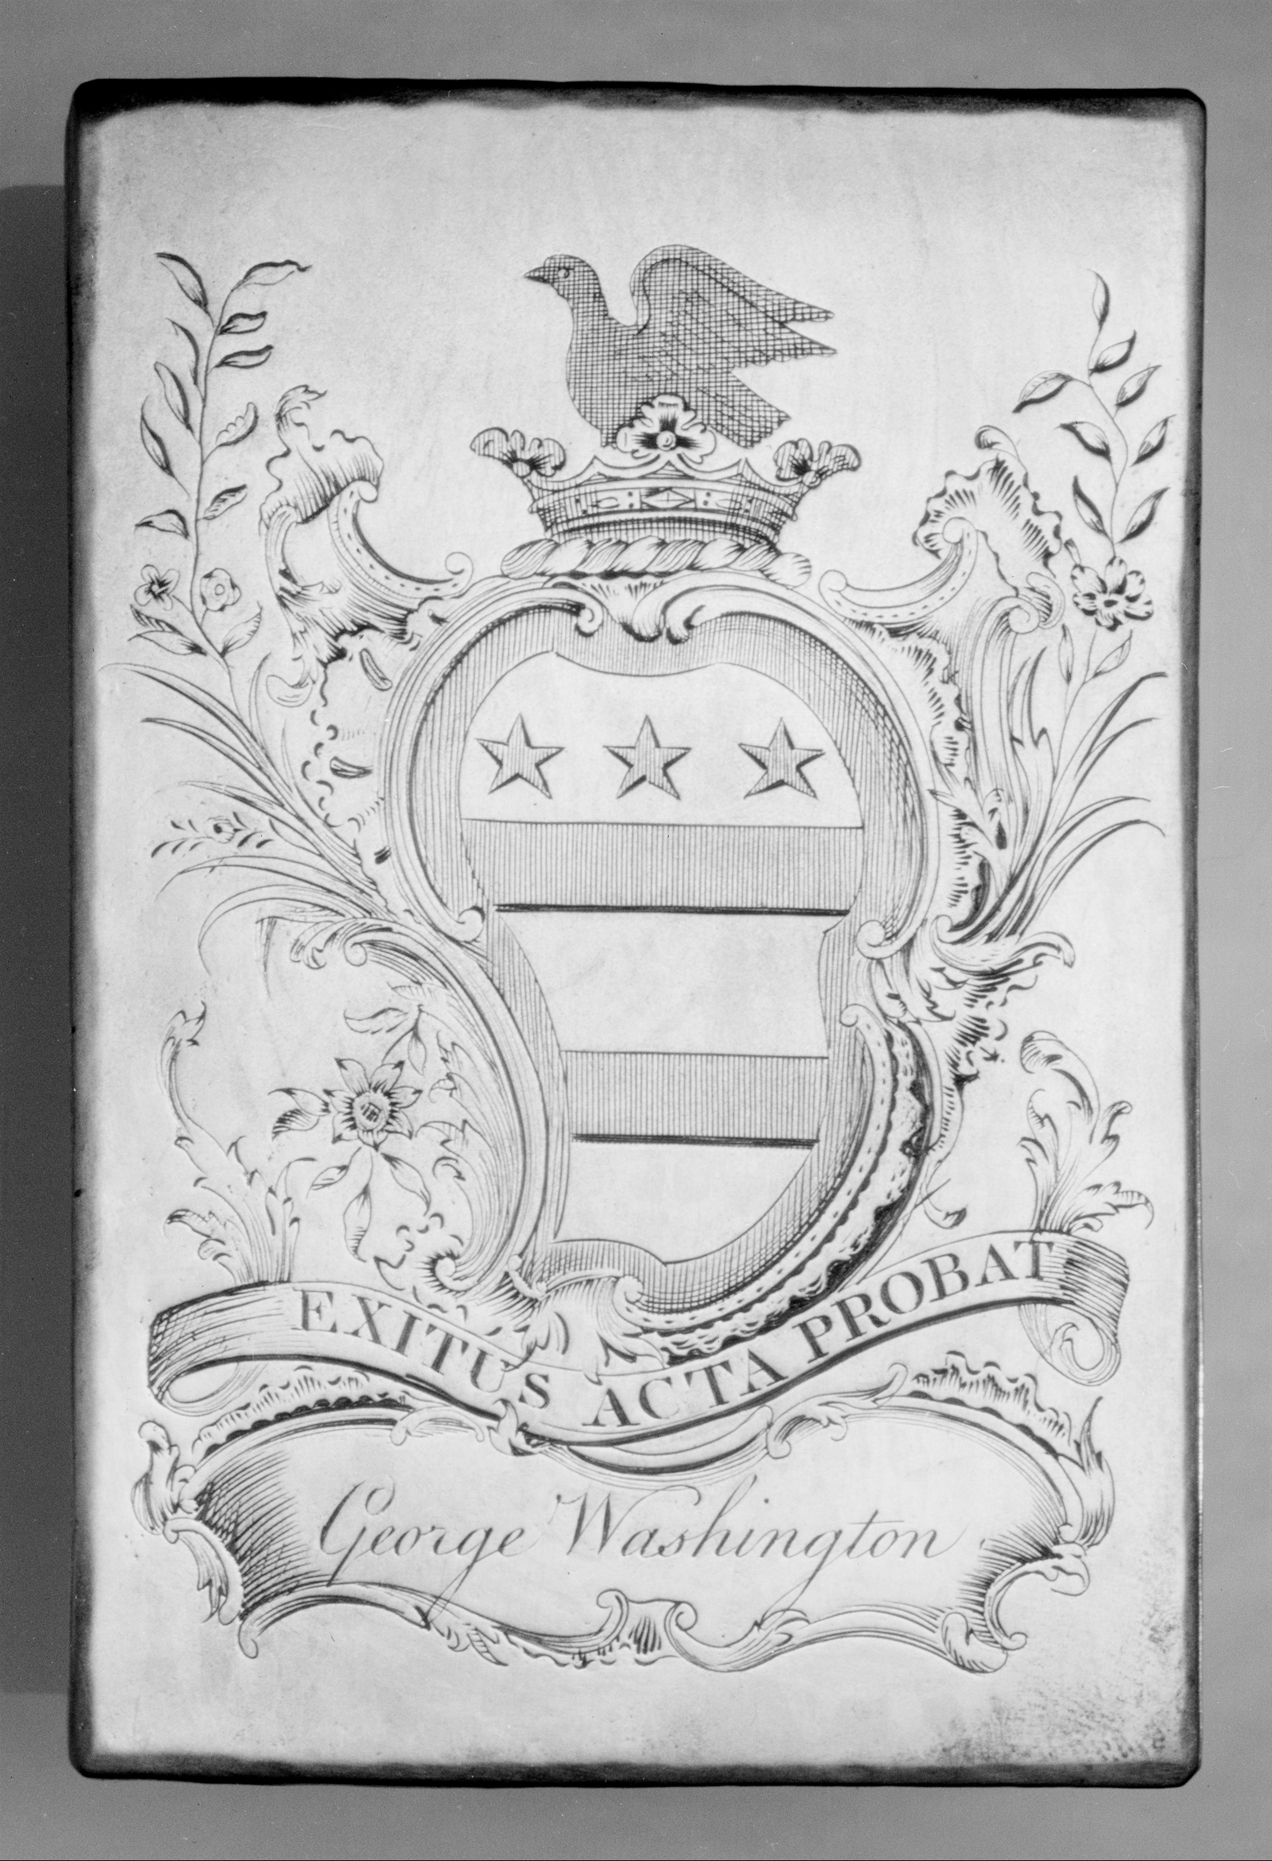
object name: plate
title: Copper Printing Plate for Bookplate of George Washington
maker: anonymous, british, 18th century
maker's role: artist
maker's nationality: british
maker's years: 1700-1800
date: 1772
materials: gilt copper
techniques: engraving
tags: birds,george washington,coat of arms